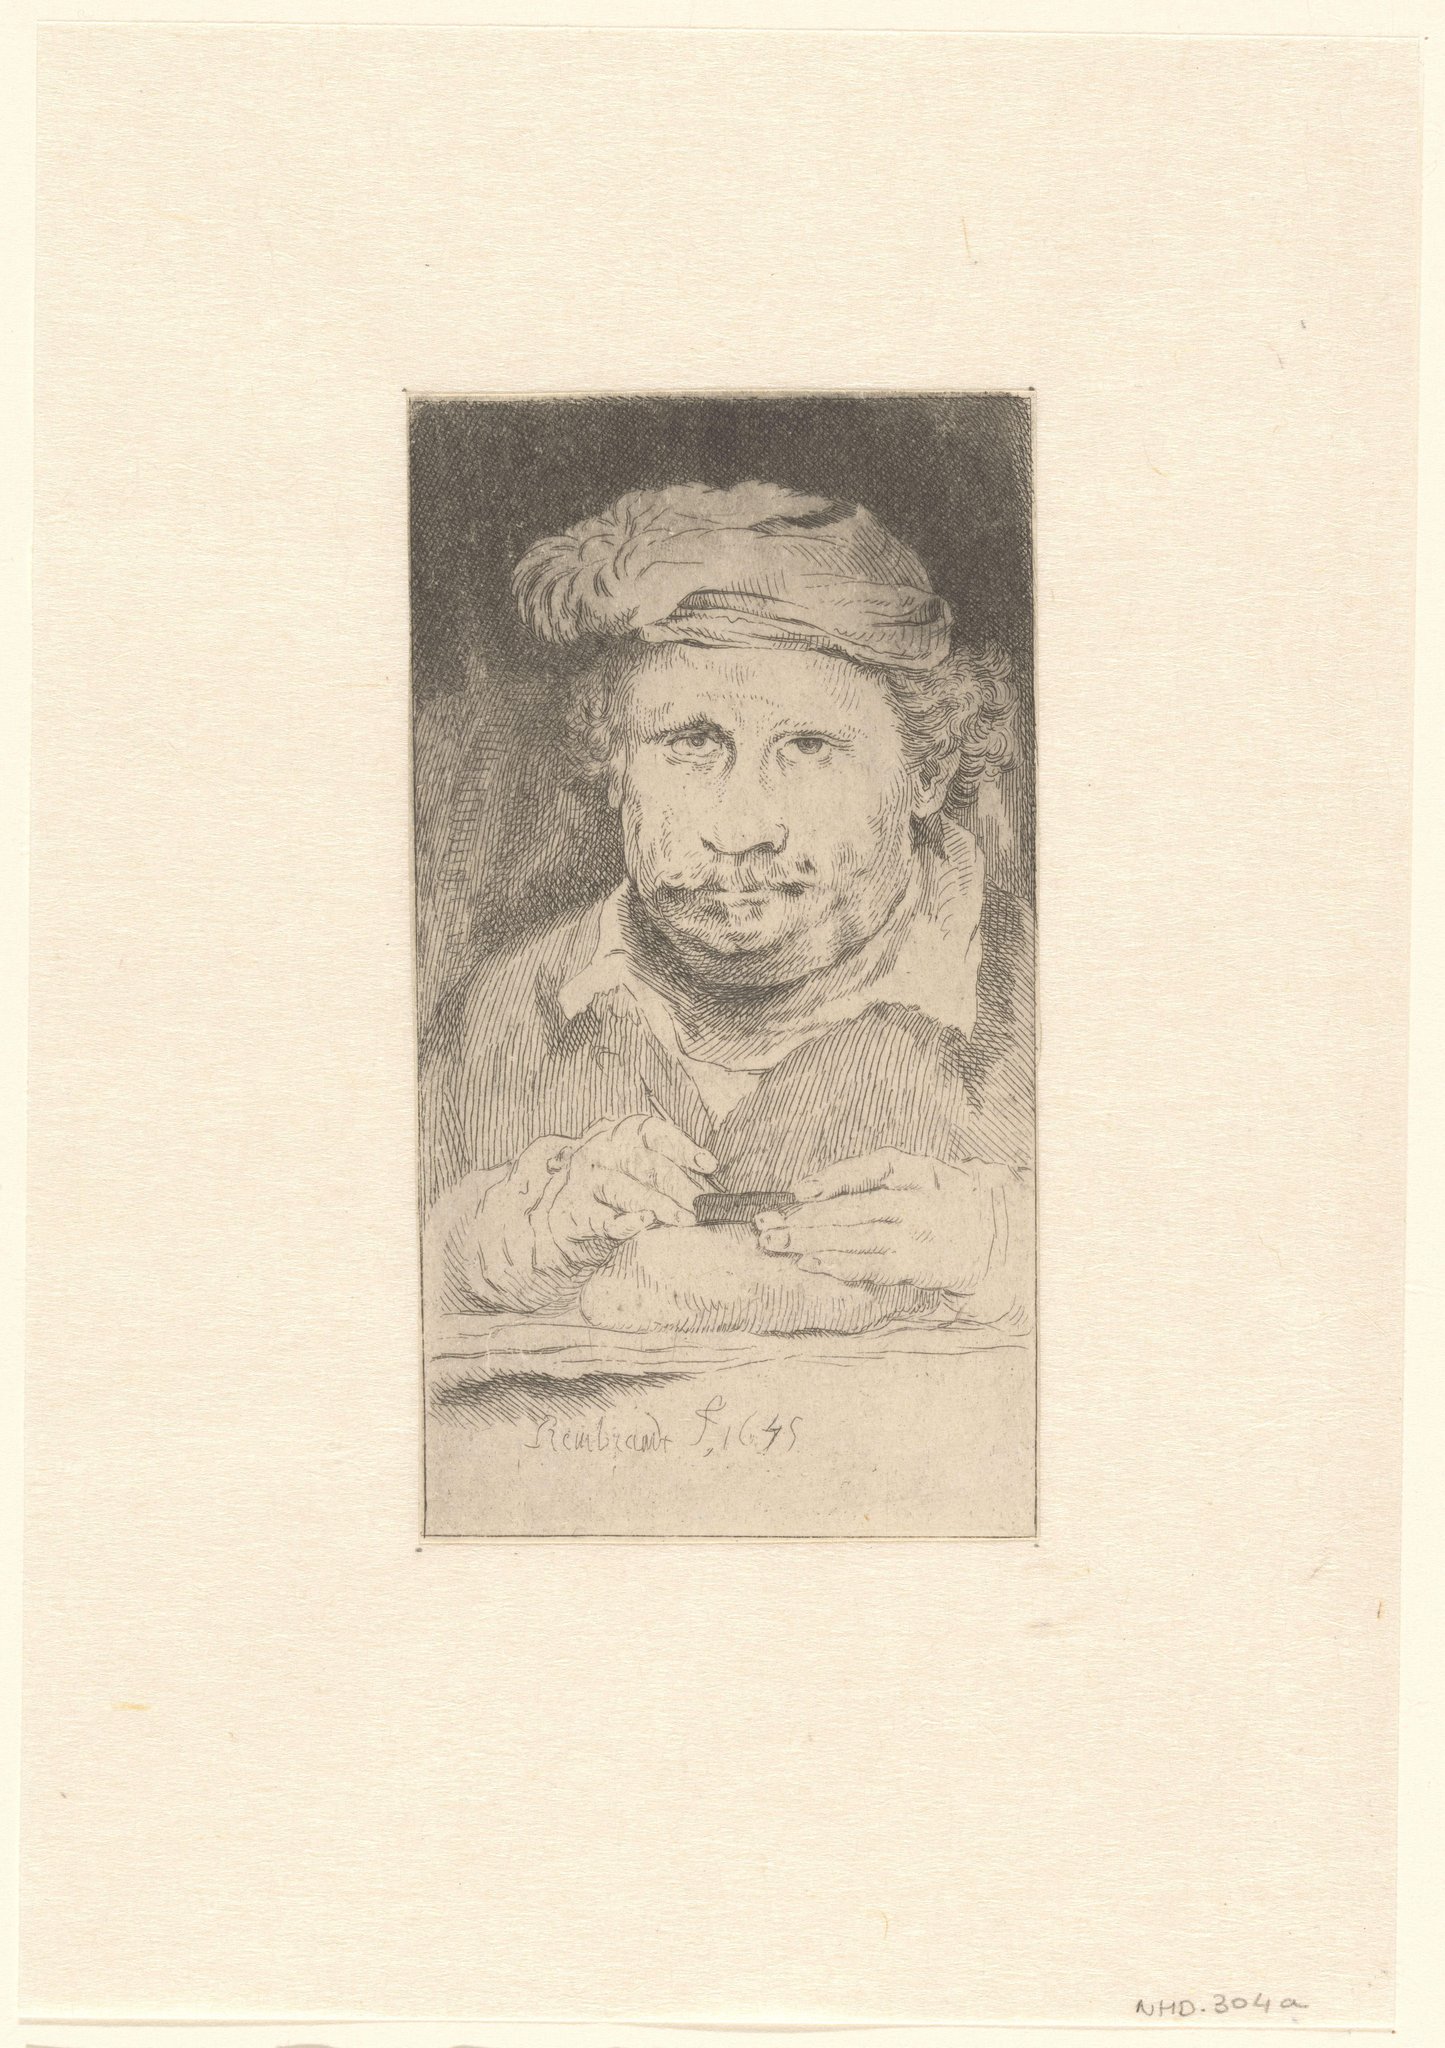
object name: print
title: Self-portrait, drawing on an etching-plate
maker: pierre françois basan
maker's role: print maker, publisher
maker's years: 1723-1797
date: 1733-1797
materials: paper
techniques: etching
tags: leiden, draughtsman, rembrandt van rijn, portrait, self-portrait of graphic artist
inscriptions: collector's mark: Lugt 2760, collector's mark: Lugt 2228